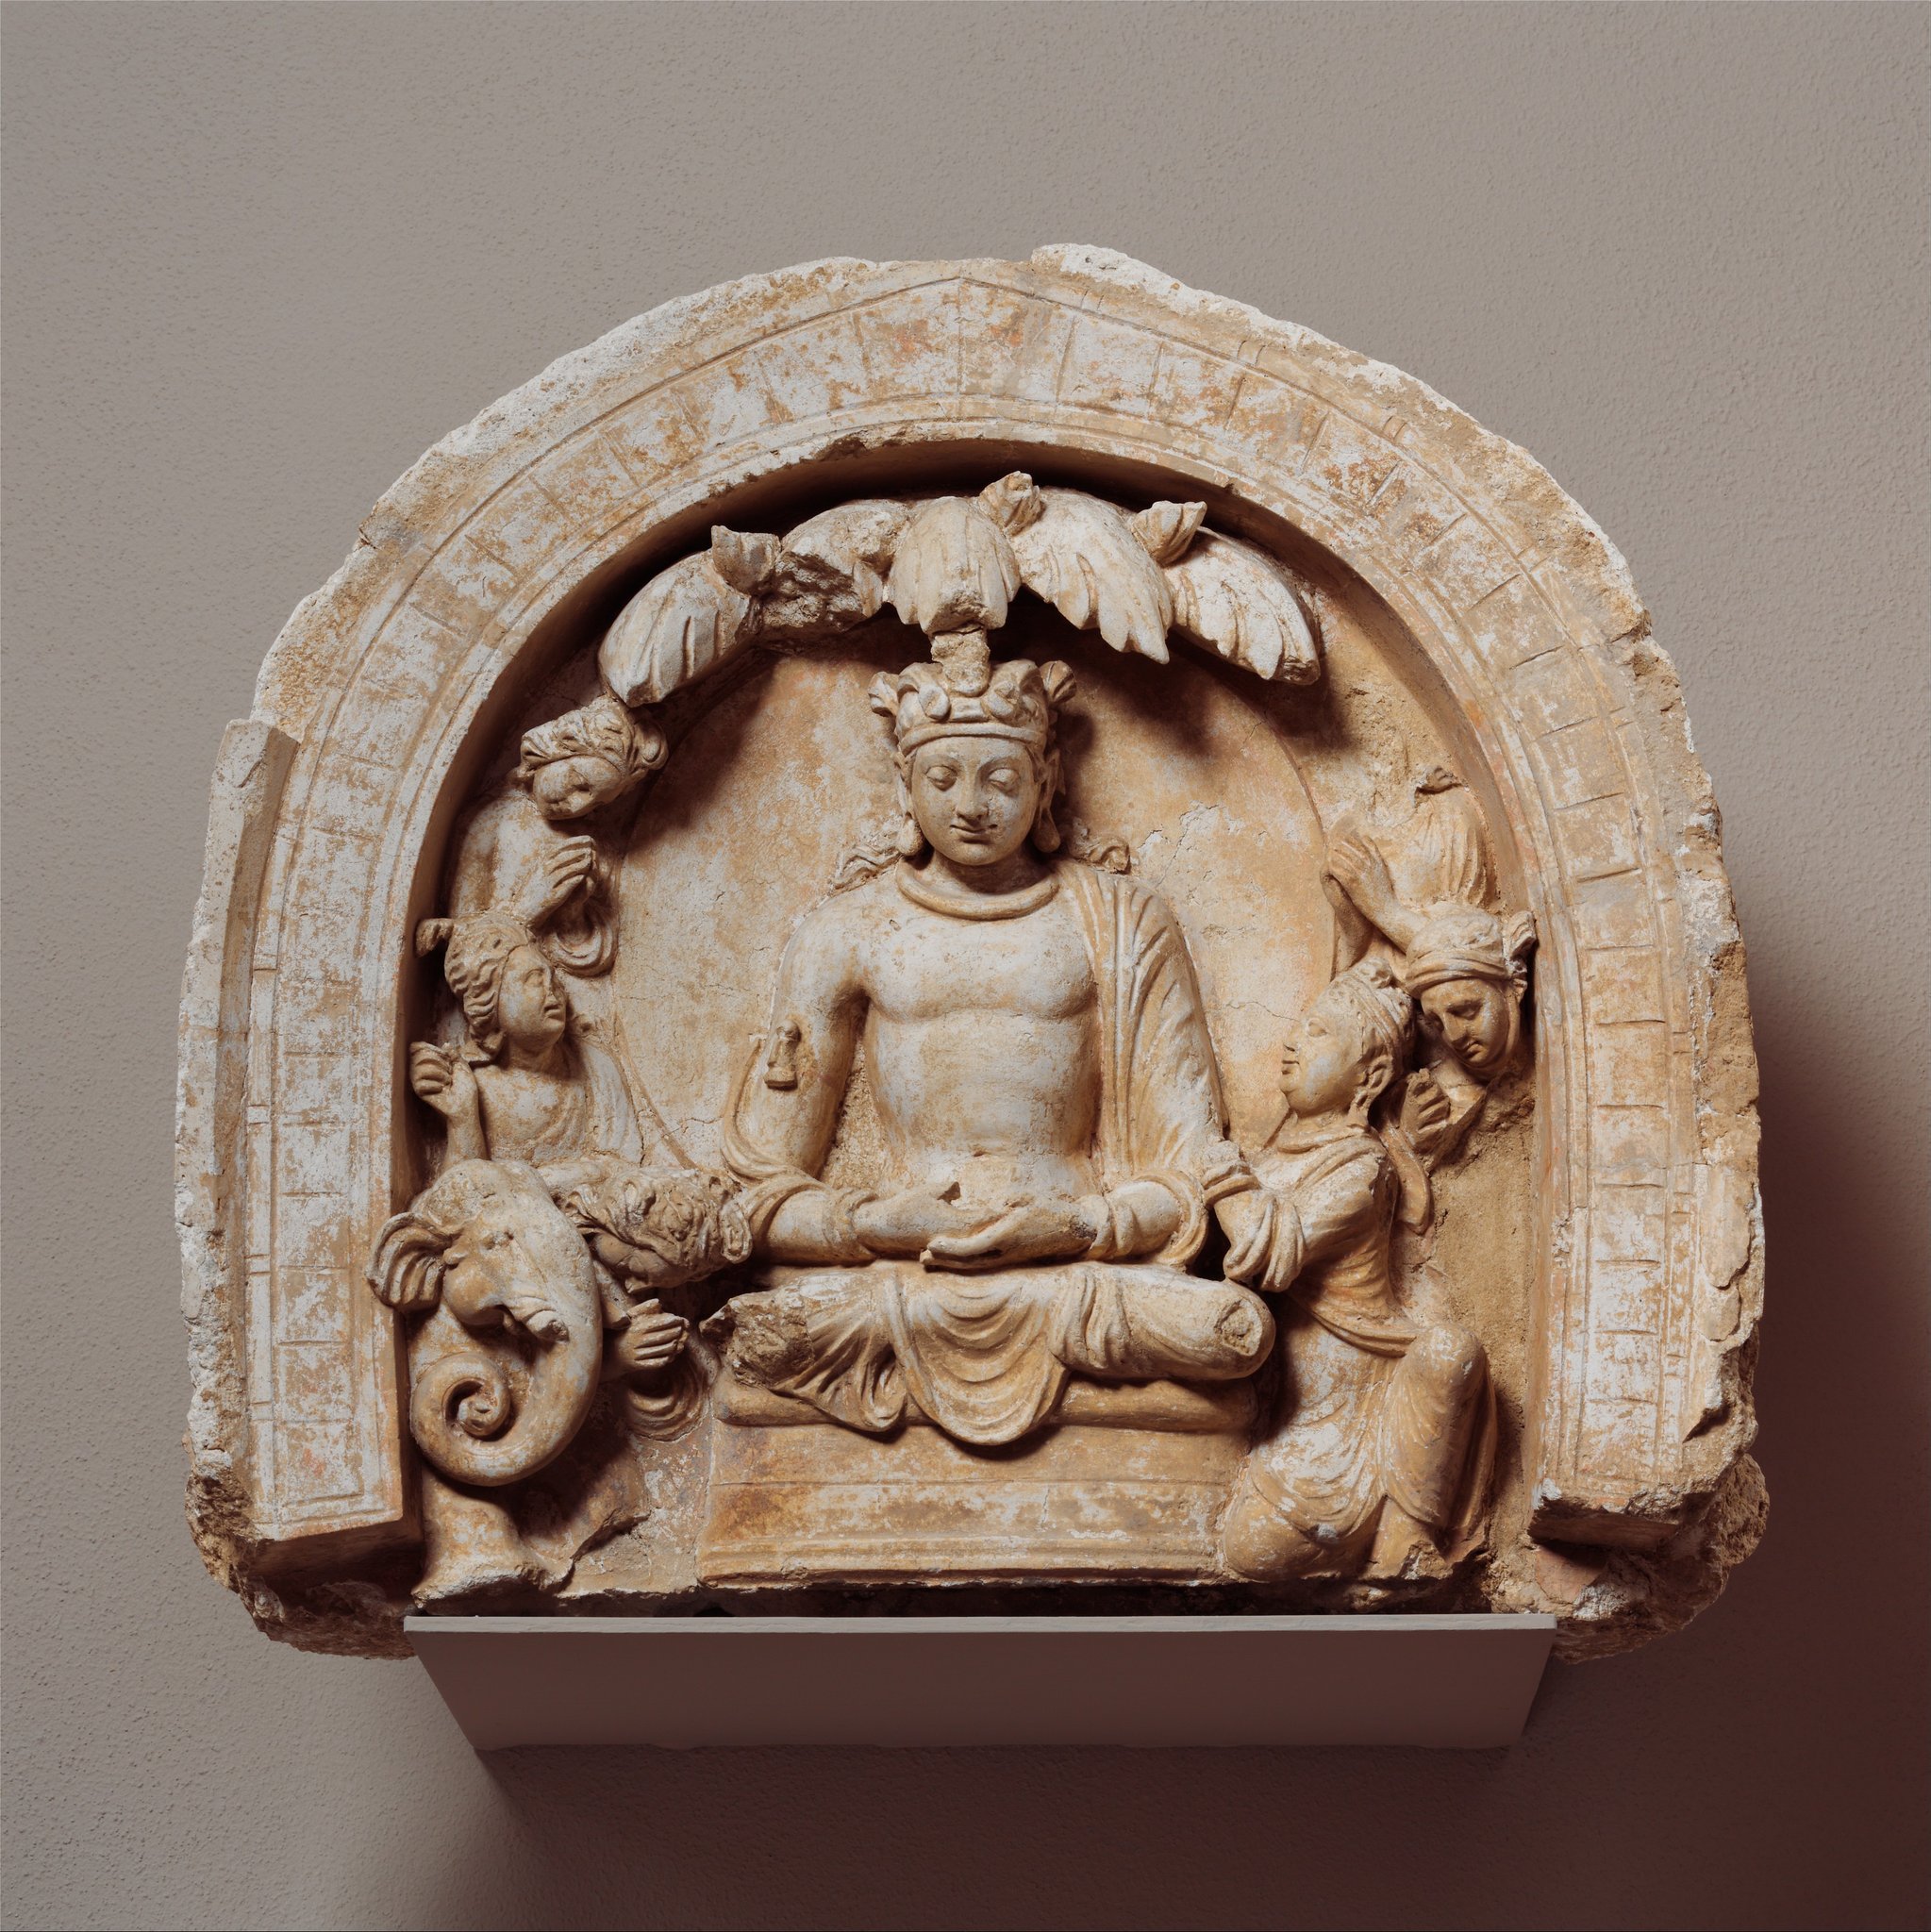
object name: lunette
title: Niche with the Seated Bodhisattva Shakyamuni Flanked by Devotees and an Elephant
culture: afghan, hadda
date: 301-500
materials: plaster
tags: gandharan,elephants,buddhism,bodhisattvas,shakyamuni